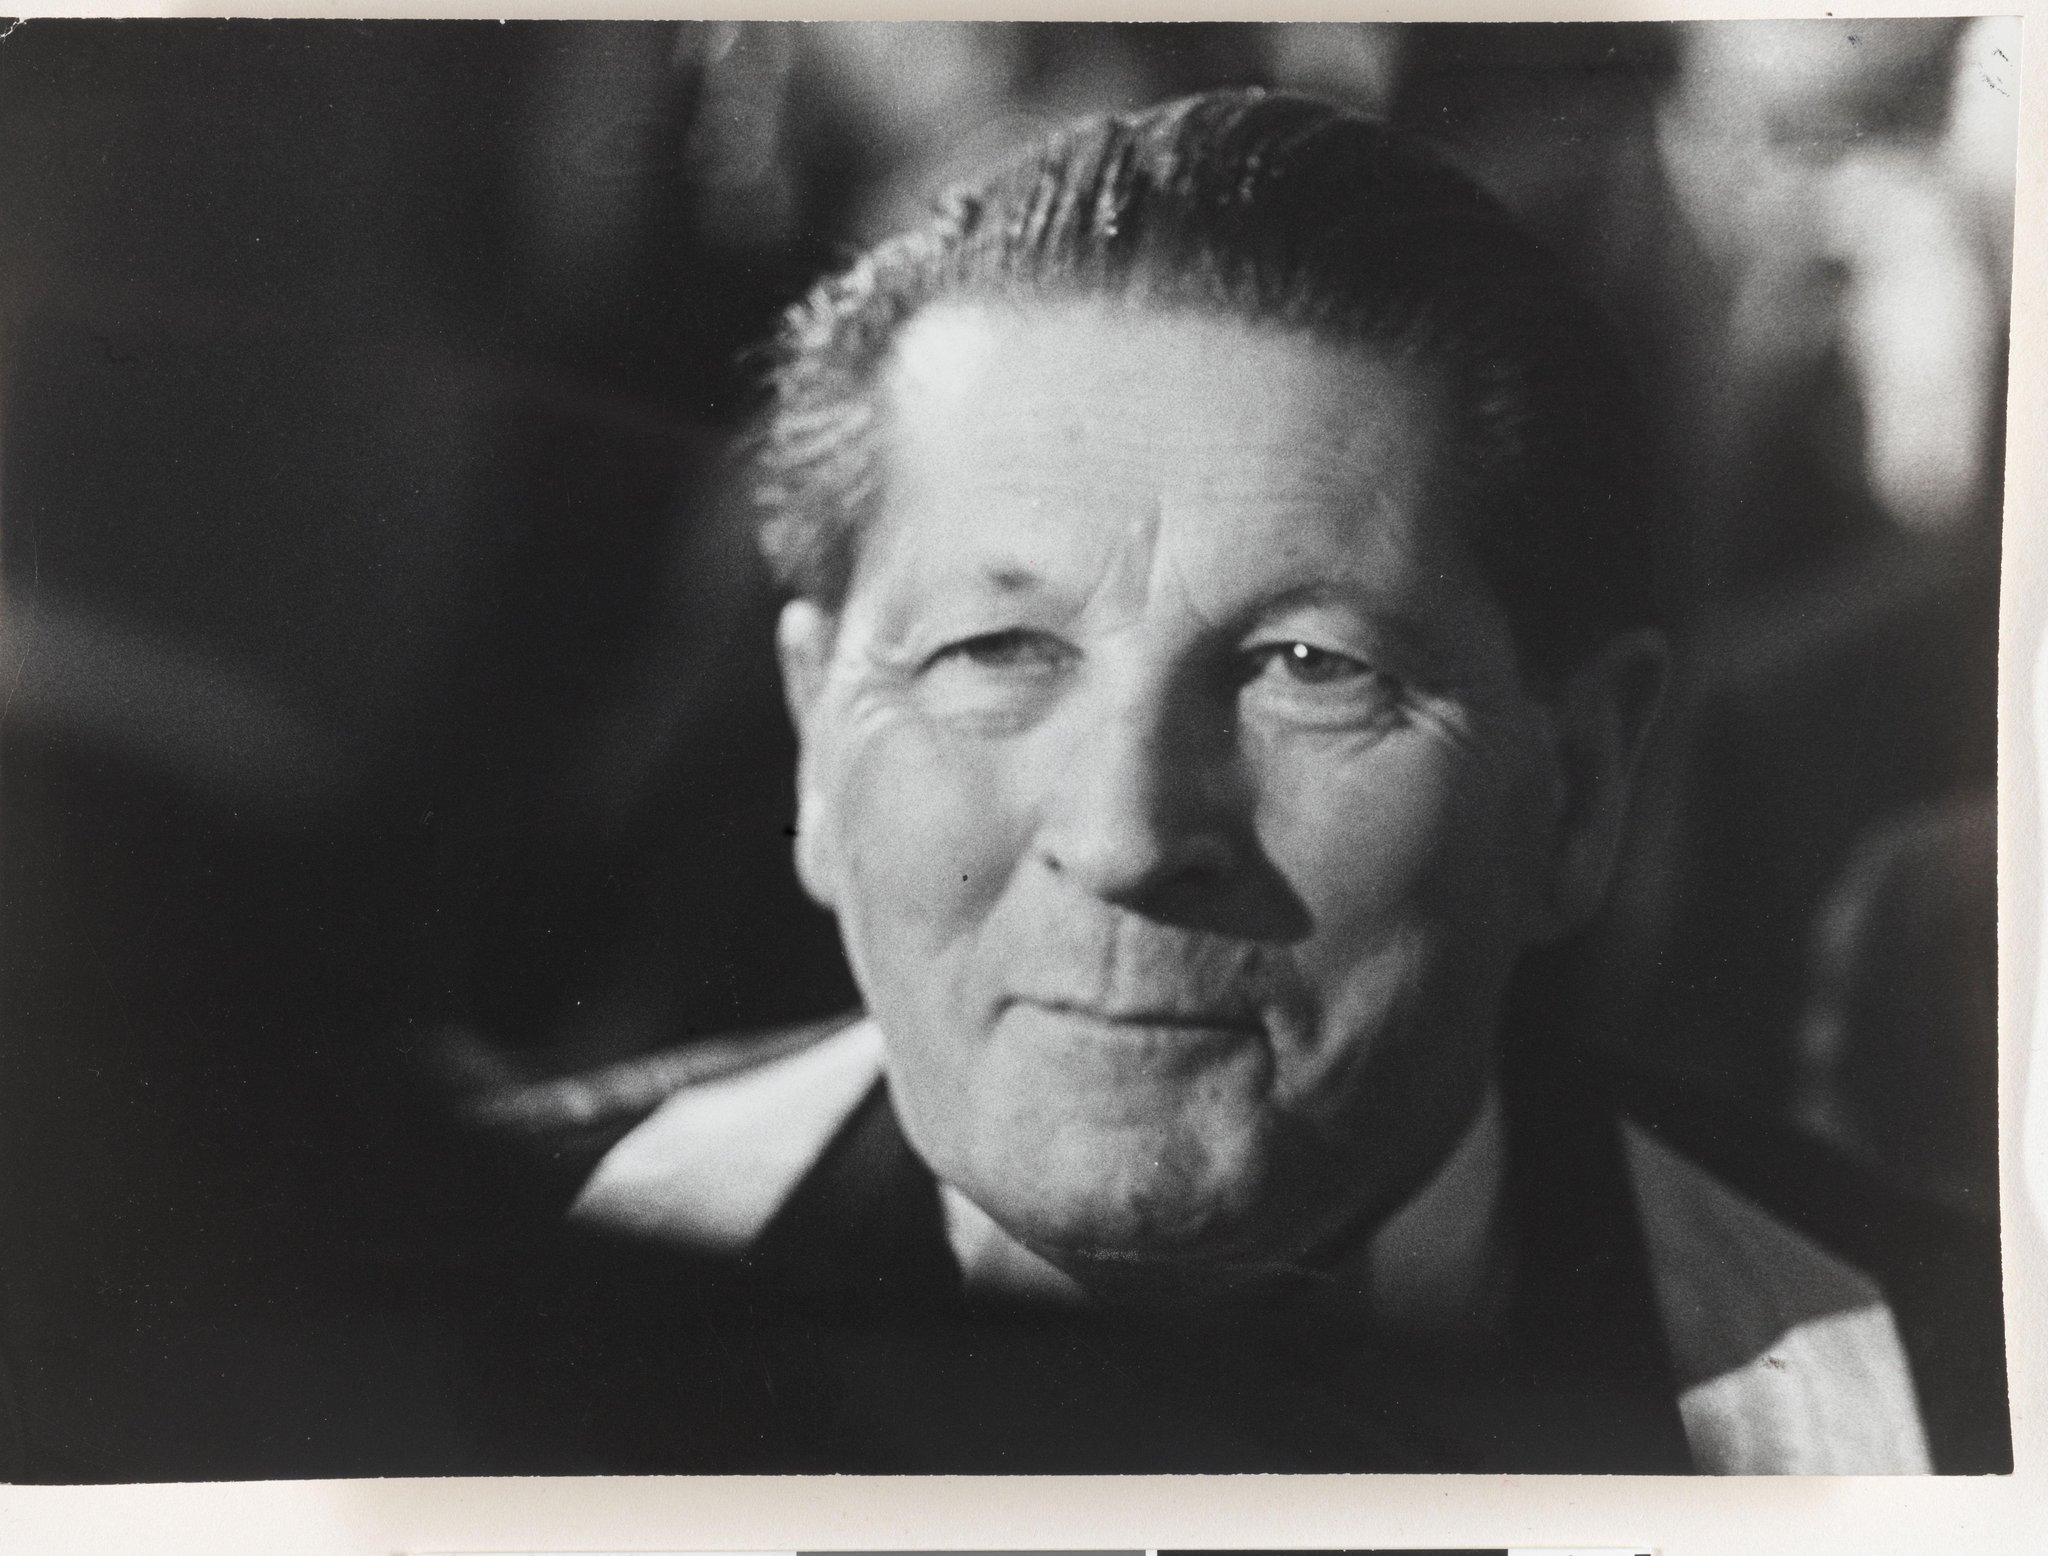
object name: photograph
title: Portret van Gerrit Rietveld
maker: Anonymous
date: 1902-1964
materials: paper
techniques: gelatin silver print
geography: netherlands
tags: utrecht, gerrit thomas rietveld, historical persons